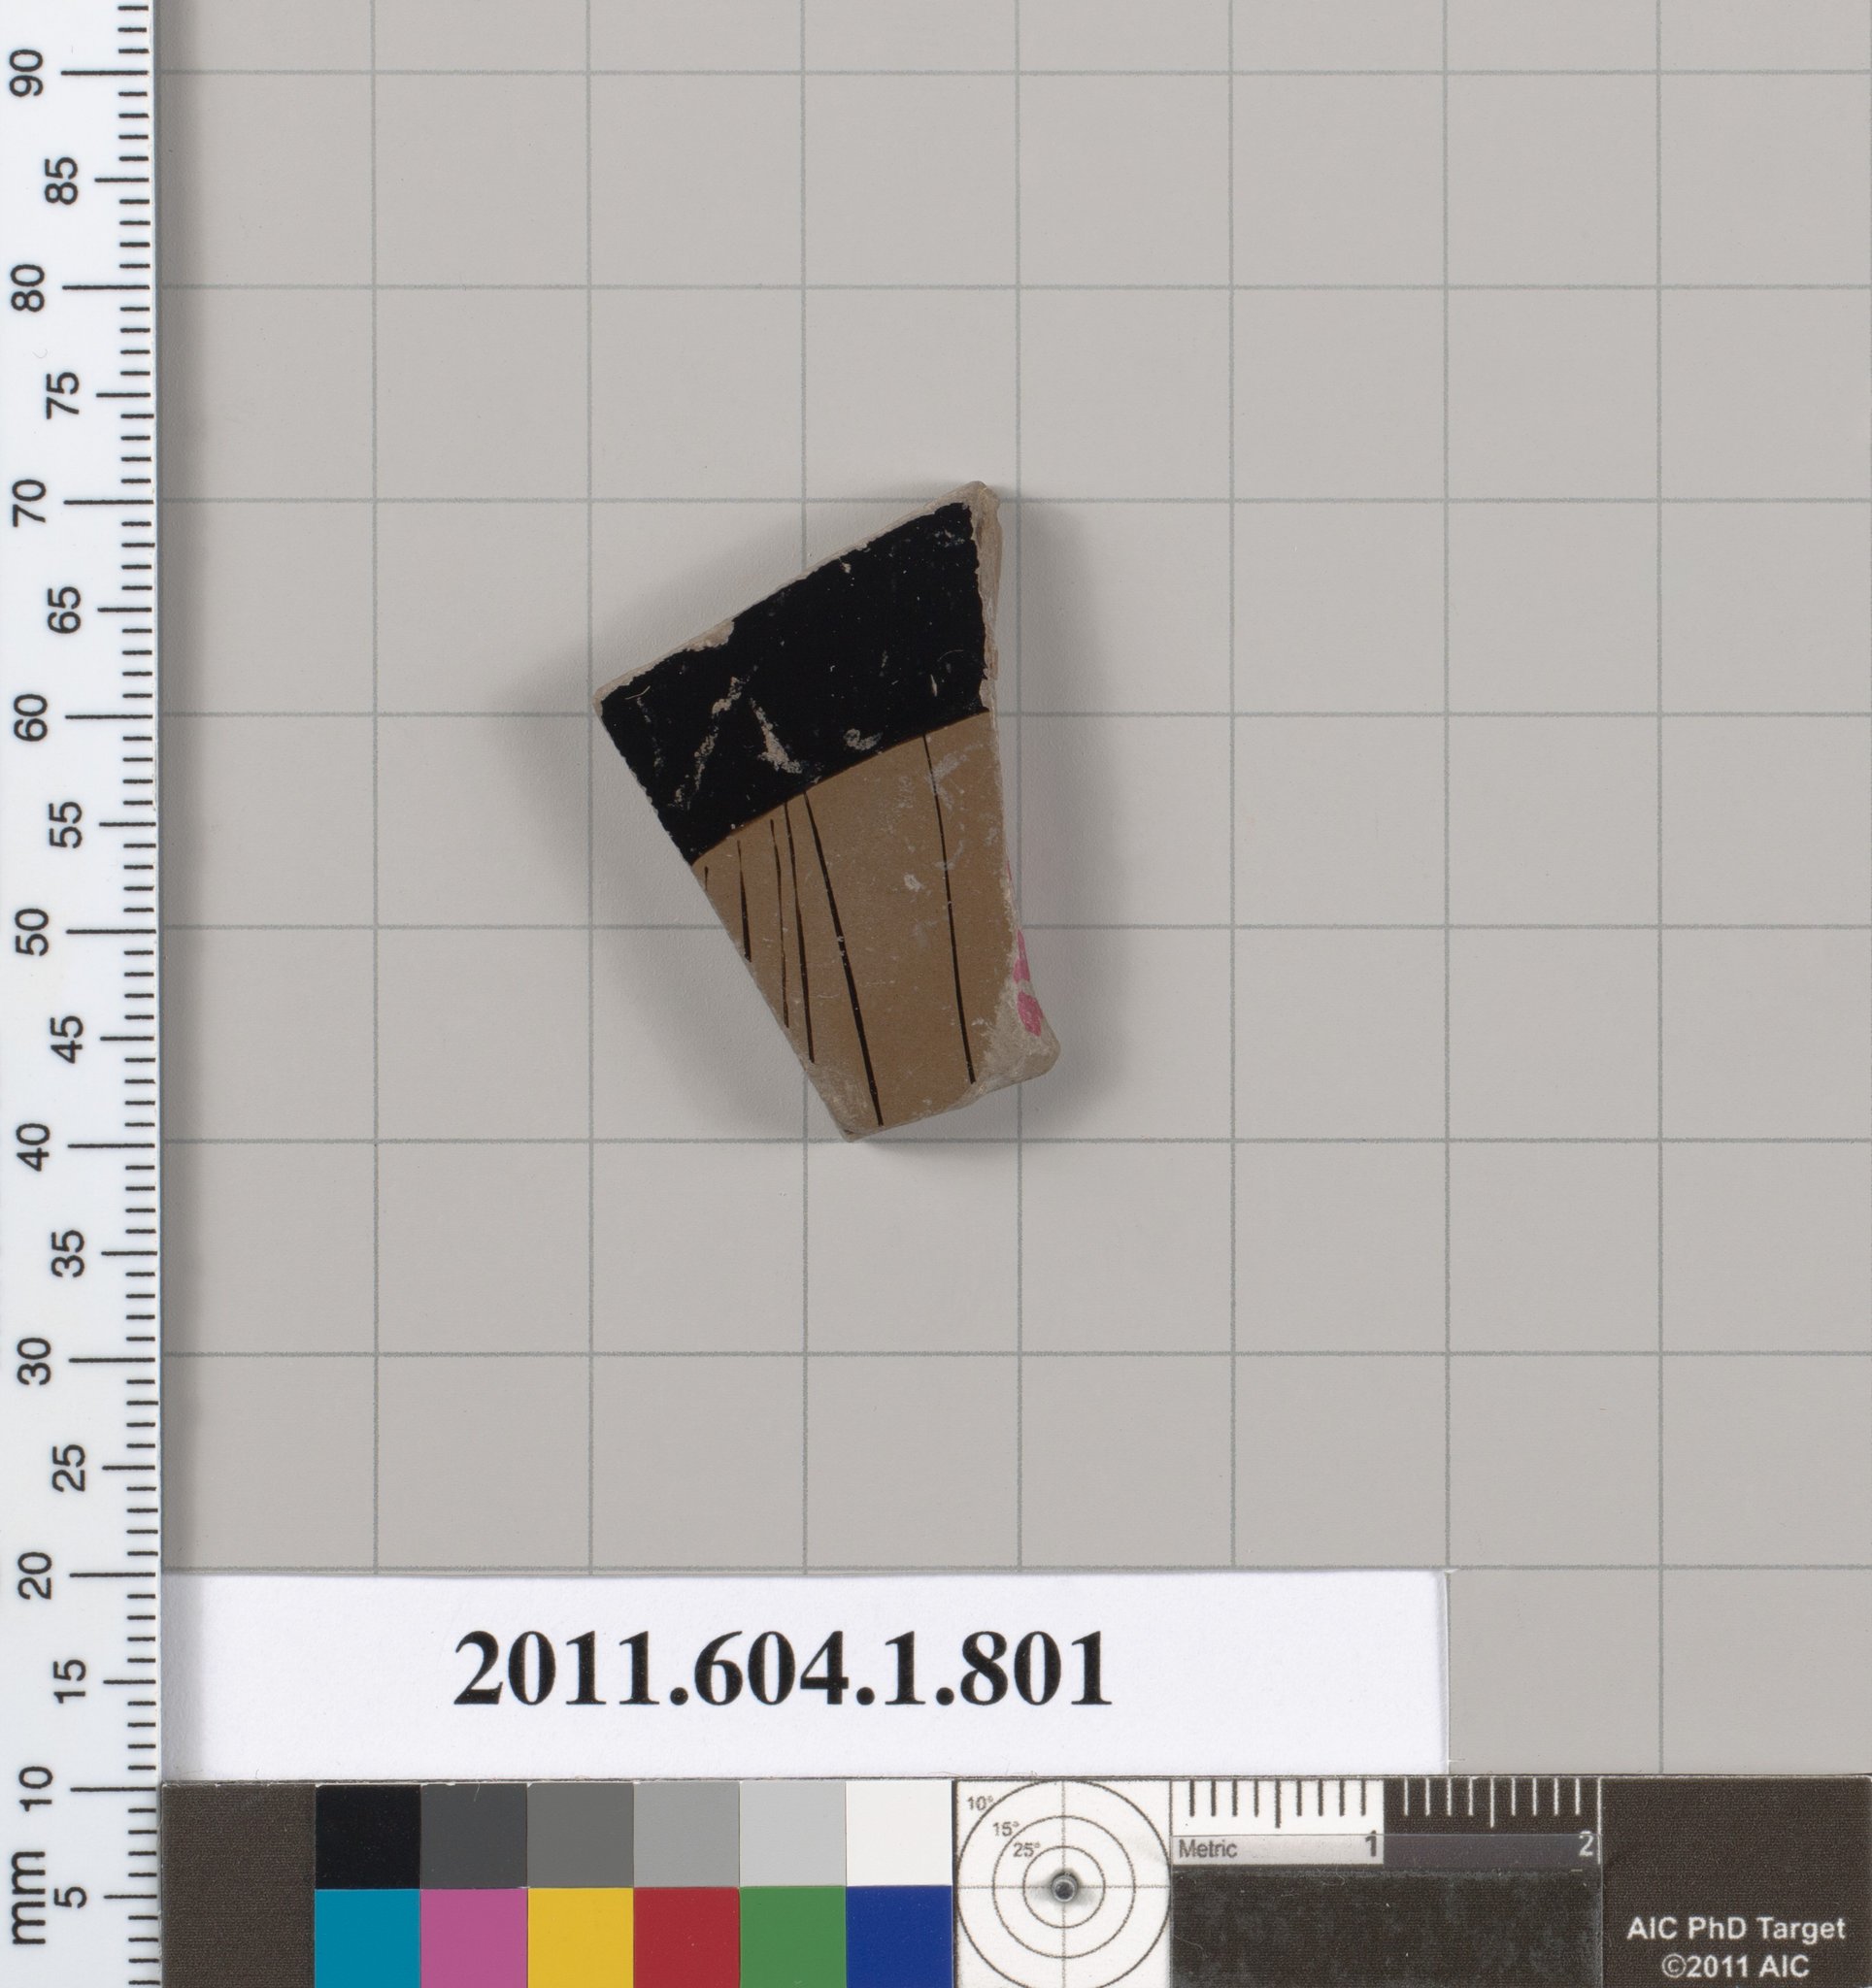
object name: kylix fragment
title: Terracotta fragment of a kylix (drinking cup)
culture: greek, attic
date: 475-451 BCE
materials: terracotta